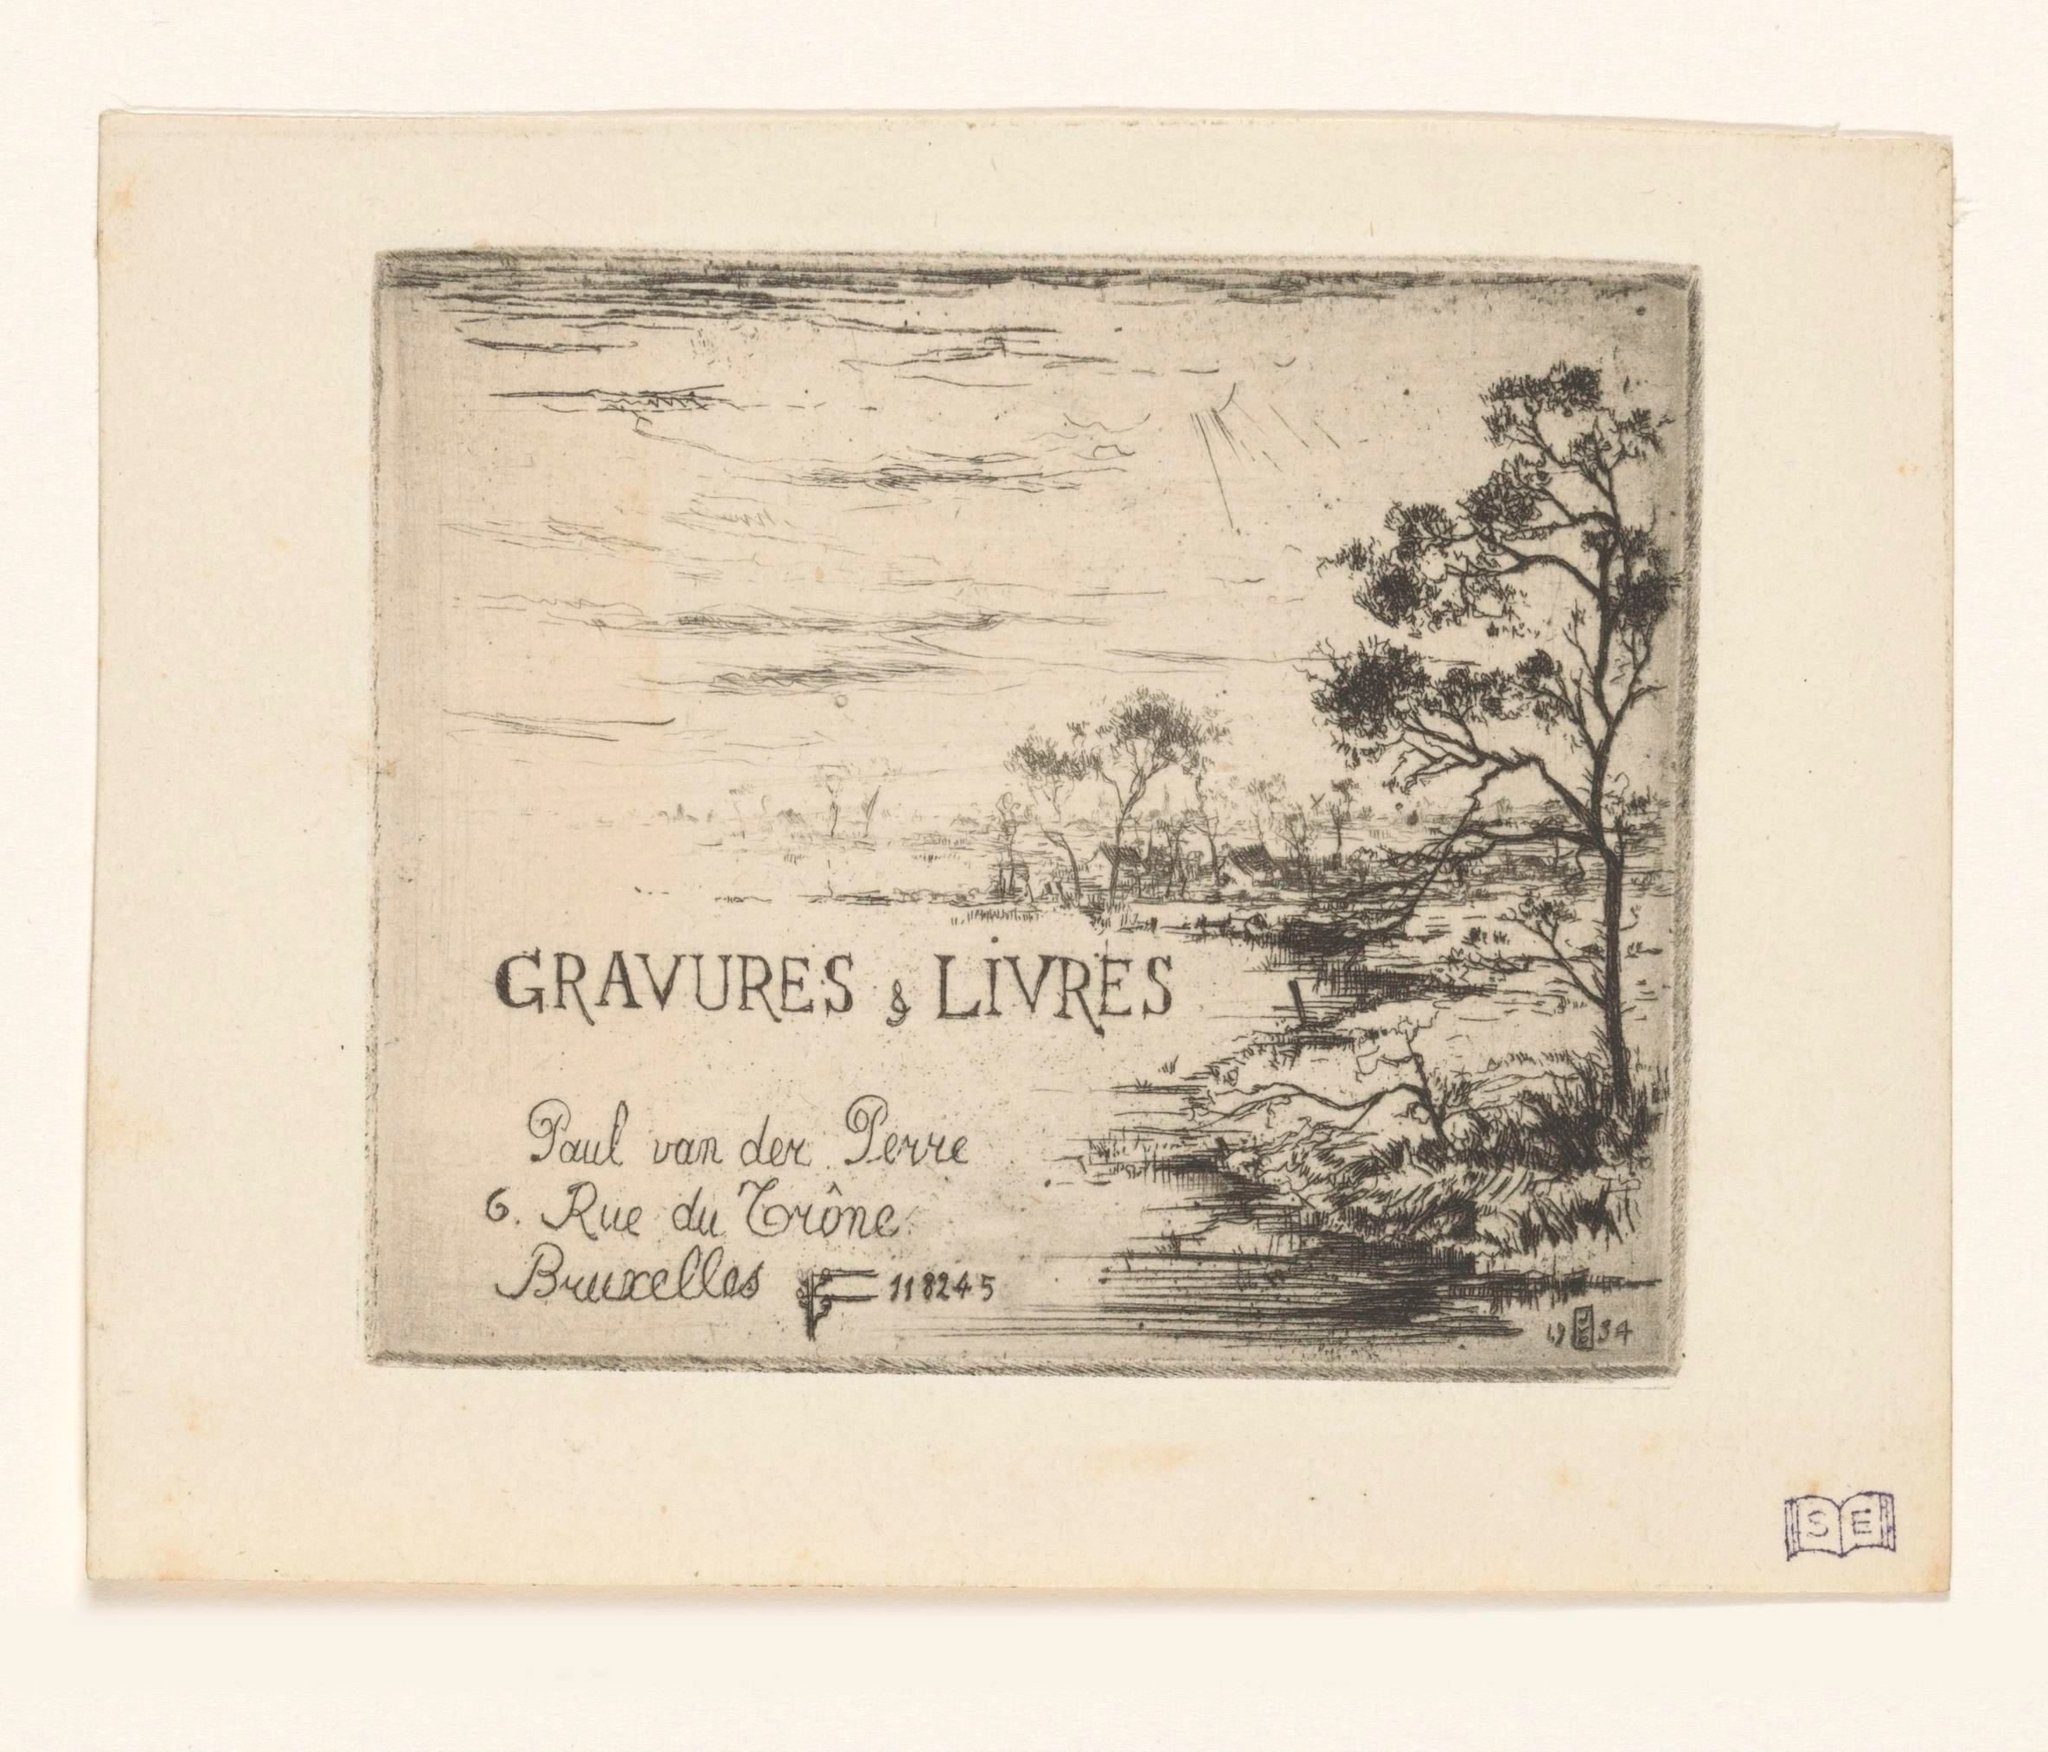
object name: print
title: Visitekaartje van boek- en prenthandelaar Paul van der Perre te Brussel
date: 1934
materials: paper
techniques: drypoint, etching, intaglio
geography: brussels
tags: landscapes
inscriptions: collector's mark: Lugt 4780, collector's mark: Lugt 2228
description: Landschap met een boom in de voorgrond en huizen in de achtergrond.